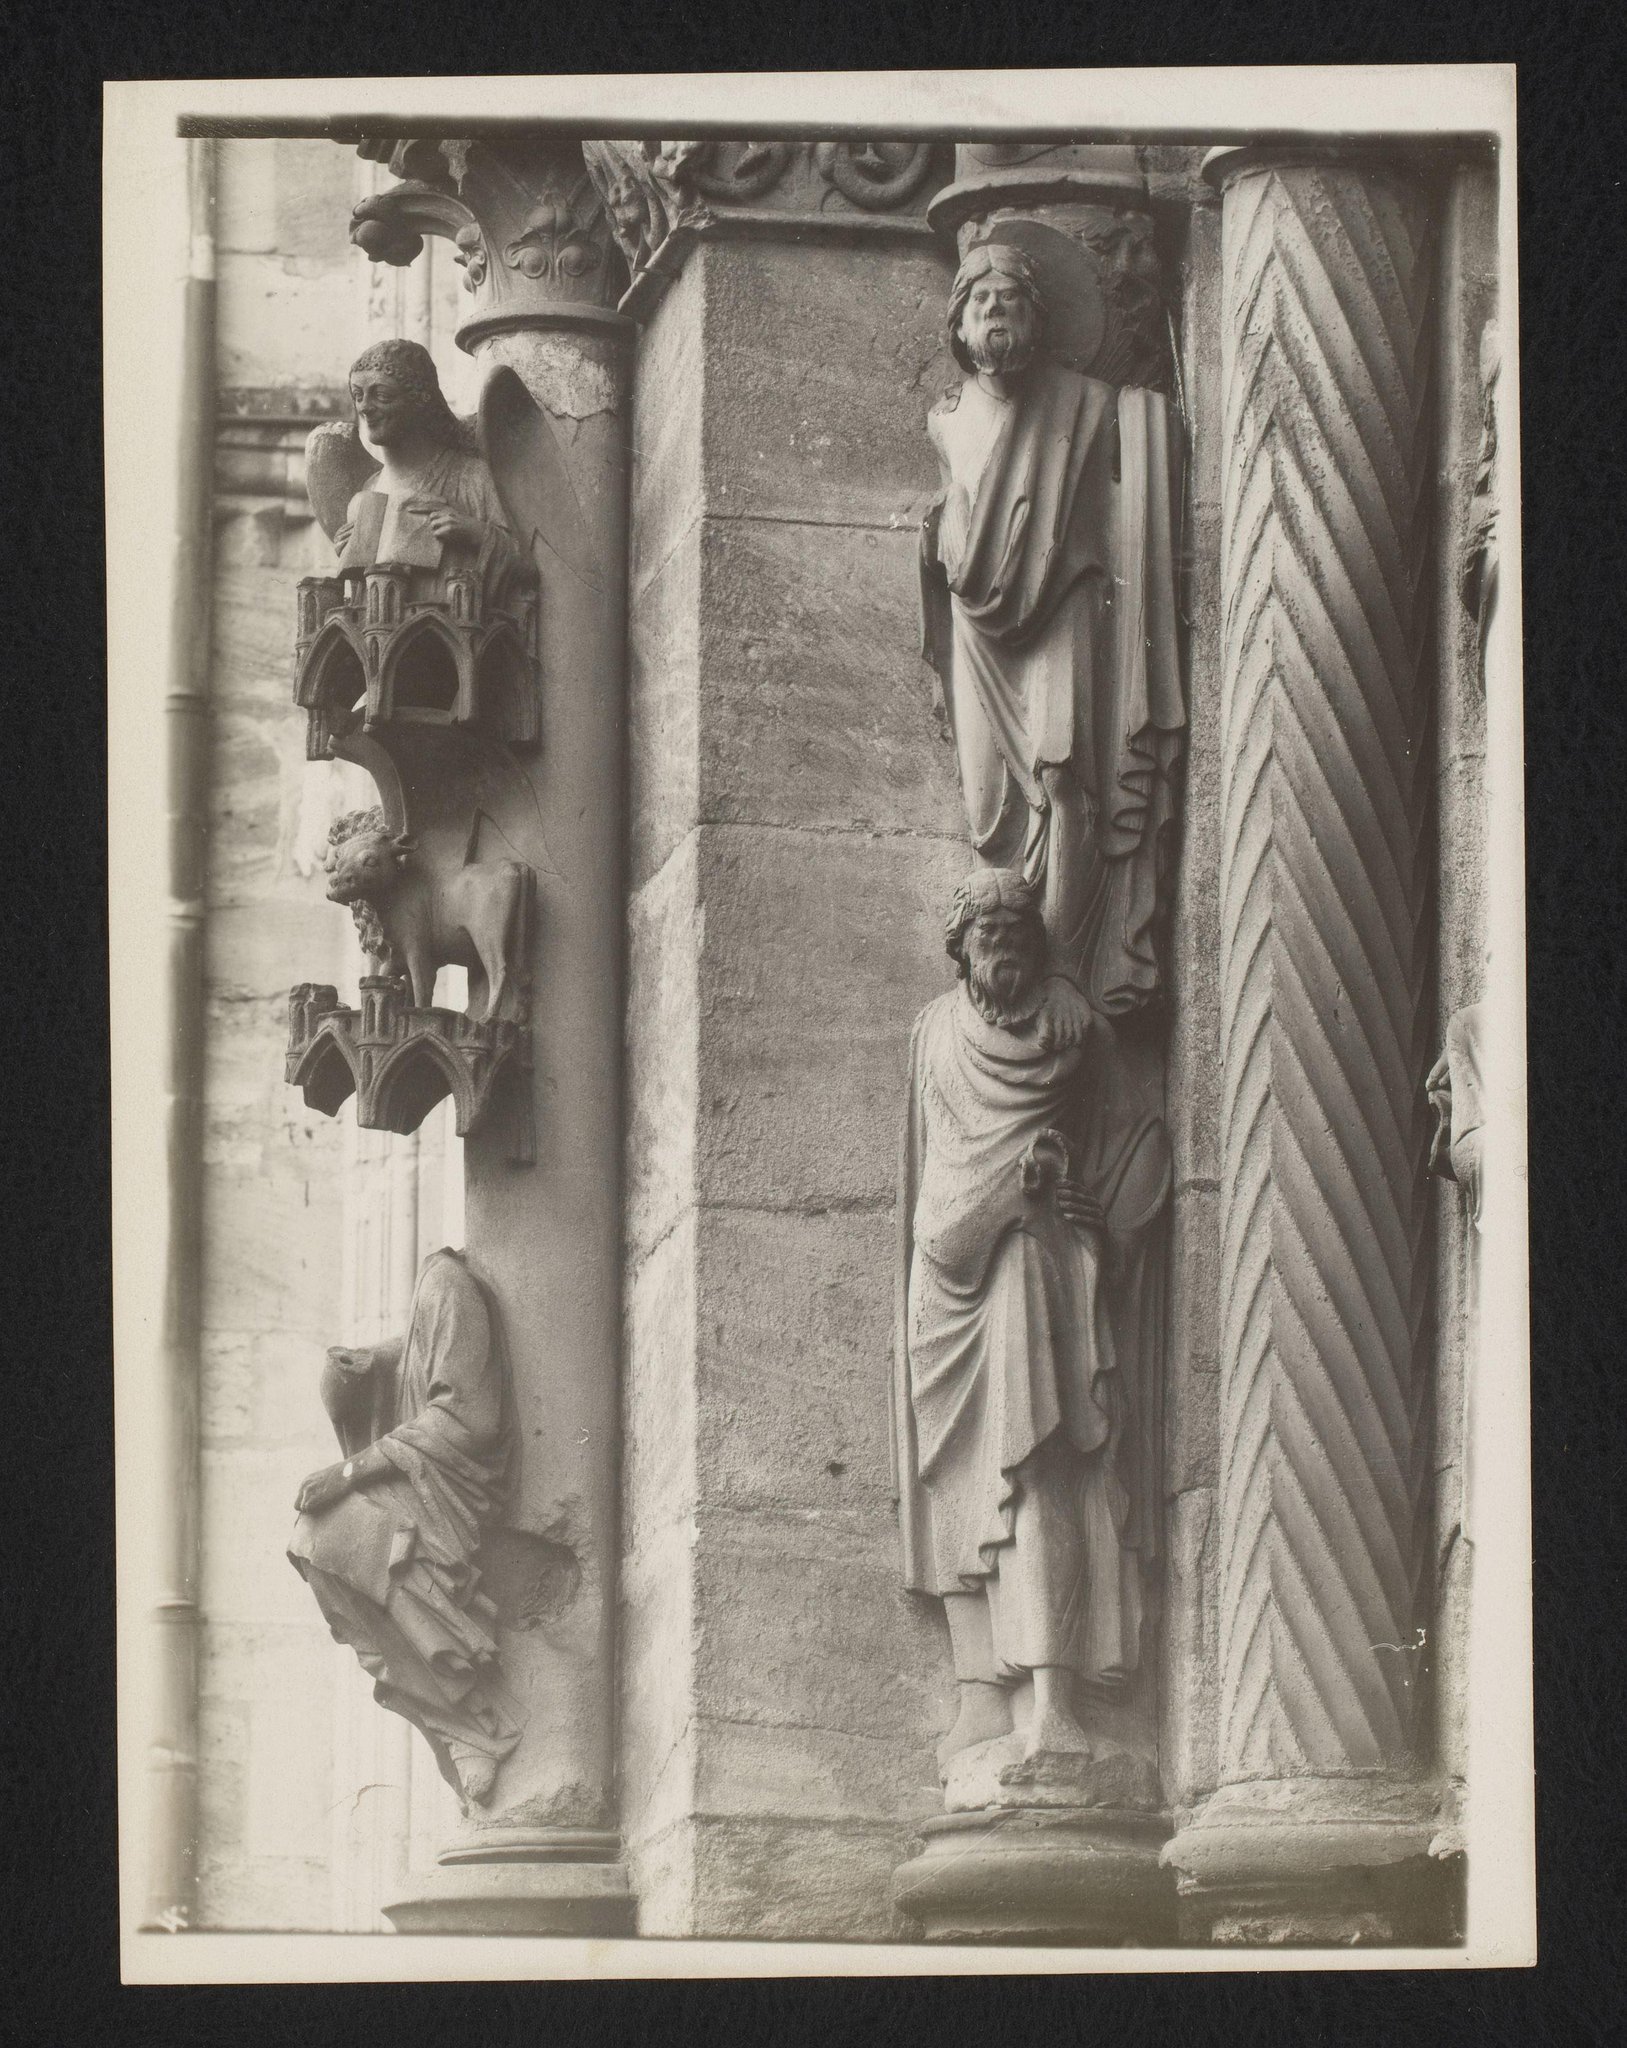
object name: photograph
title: Adamspforte, Evangelisten u. Statuensäule li.l.v.N.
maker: Anonymous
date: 1900-1920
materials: paper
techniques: gelatin silver print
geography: bamberg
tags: church (exterior)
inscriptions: number: ‘64’, inscription: ‘Kunsthist. Seminar/ Marburg (Lahn)/ Photogr. Abteilung/ Vervielfältigung/ untersagt.’